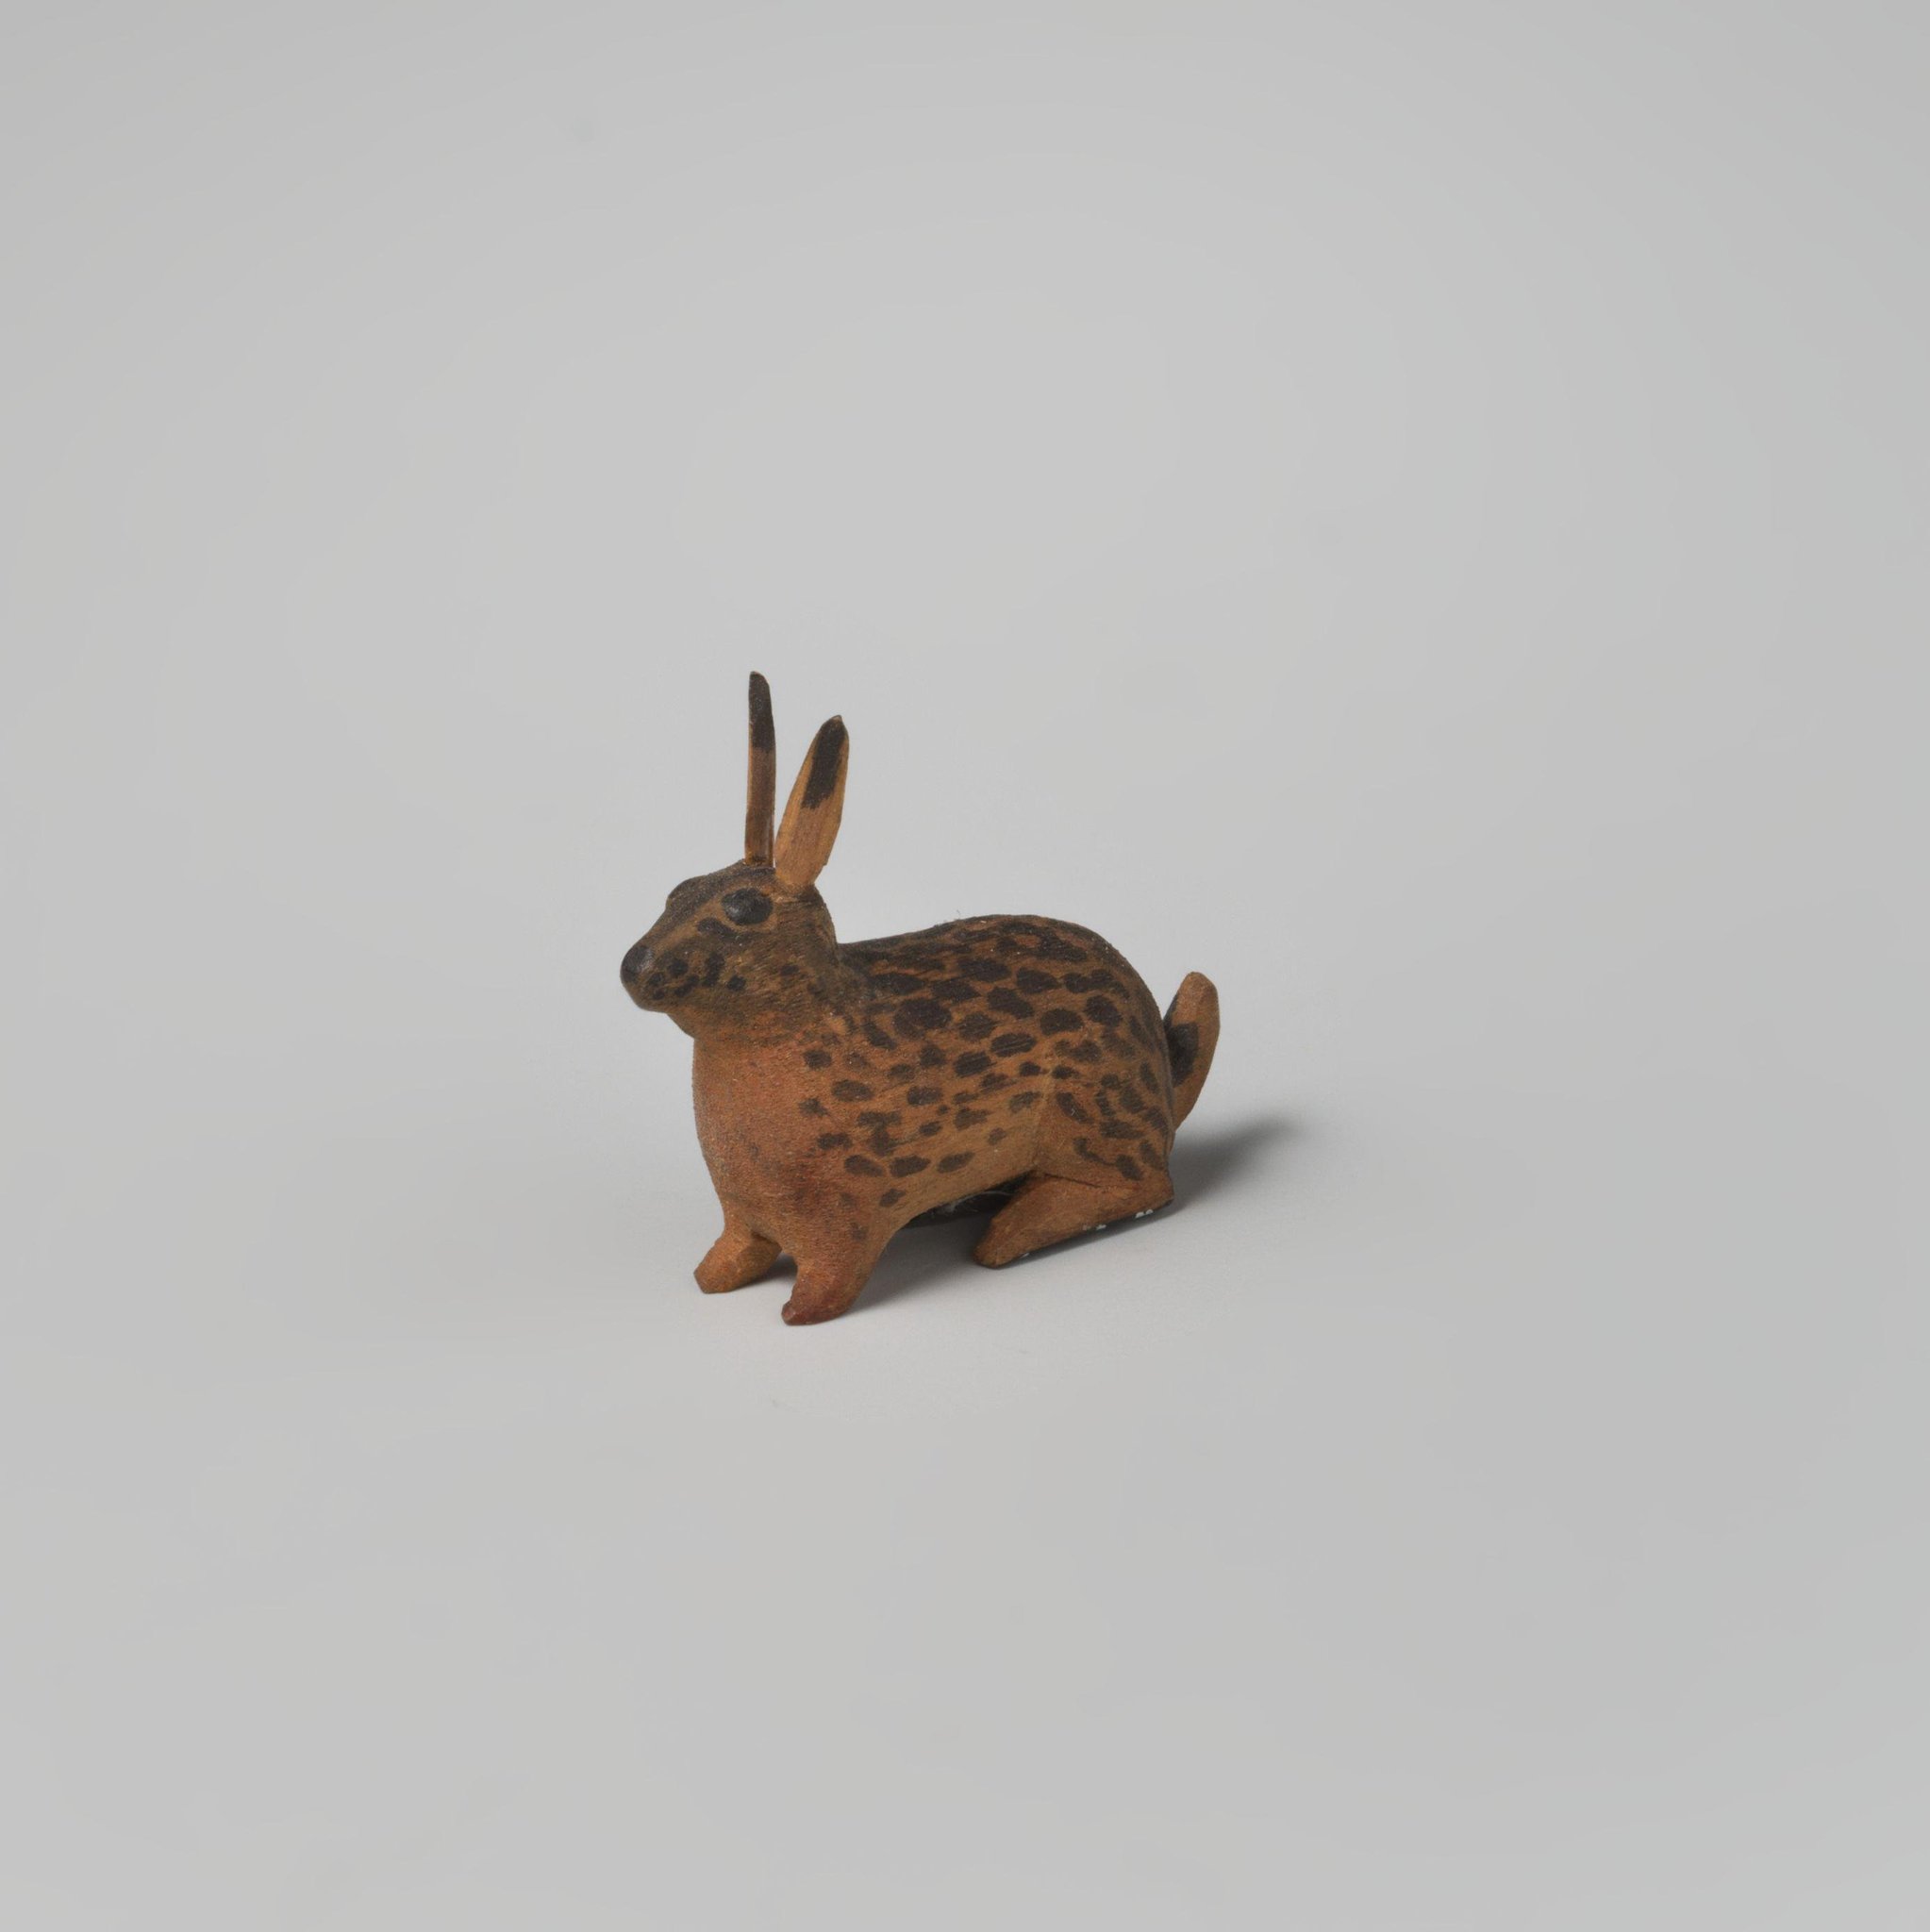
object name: miniature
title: Konijn, bruin met zwarte vlekken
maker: Anonymous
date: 1800-1899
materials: wood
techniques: cutting, painted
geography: germany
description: Konijn, gesneden uit hout, bruin geschilderd met zwarte vlekken.